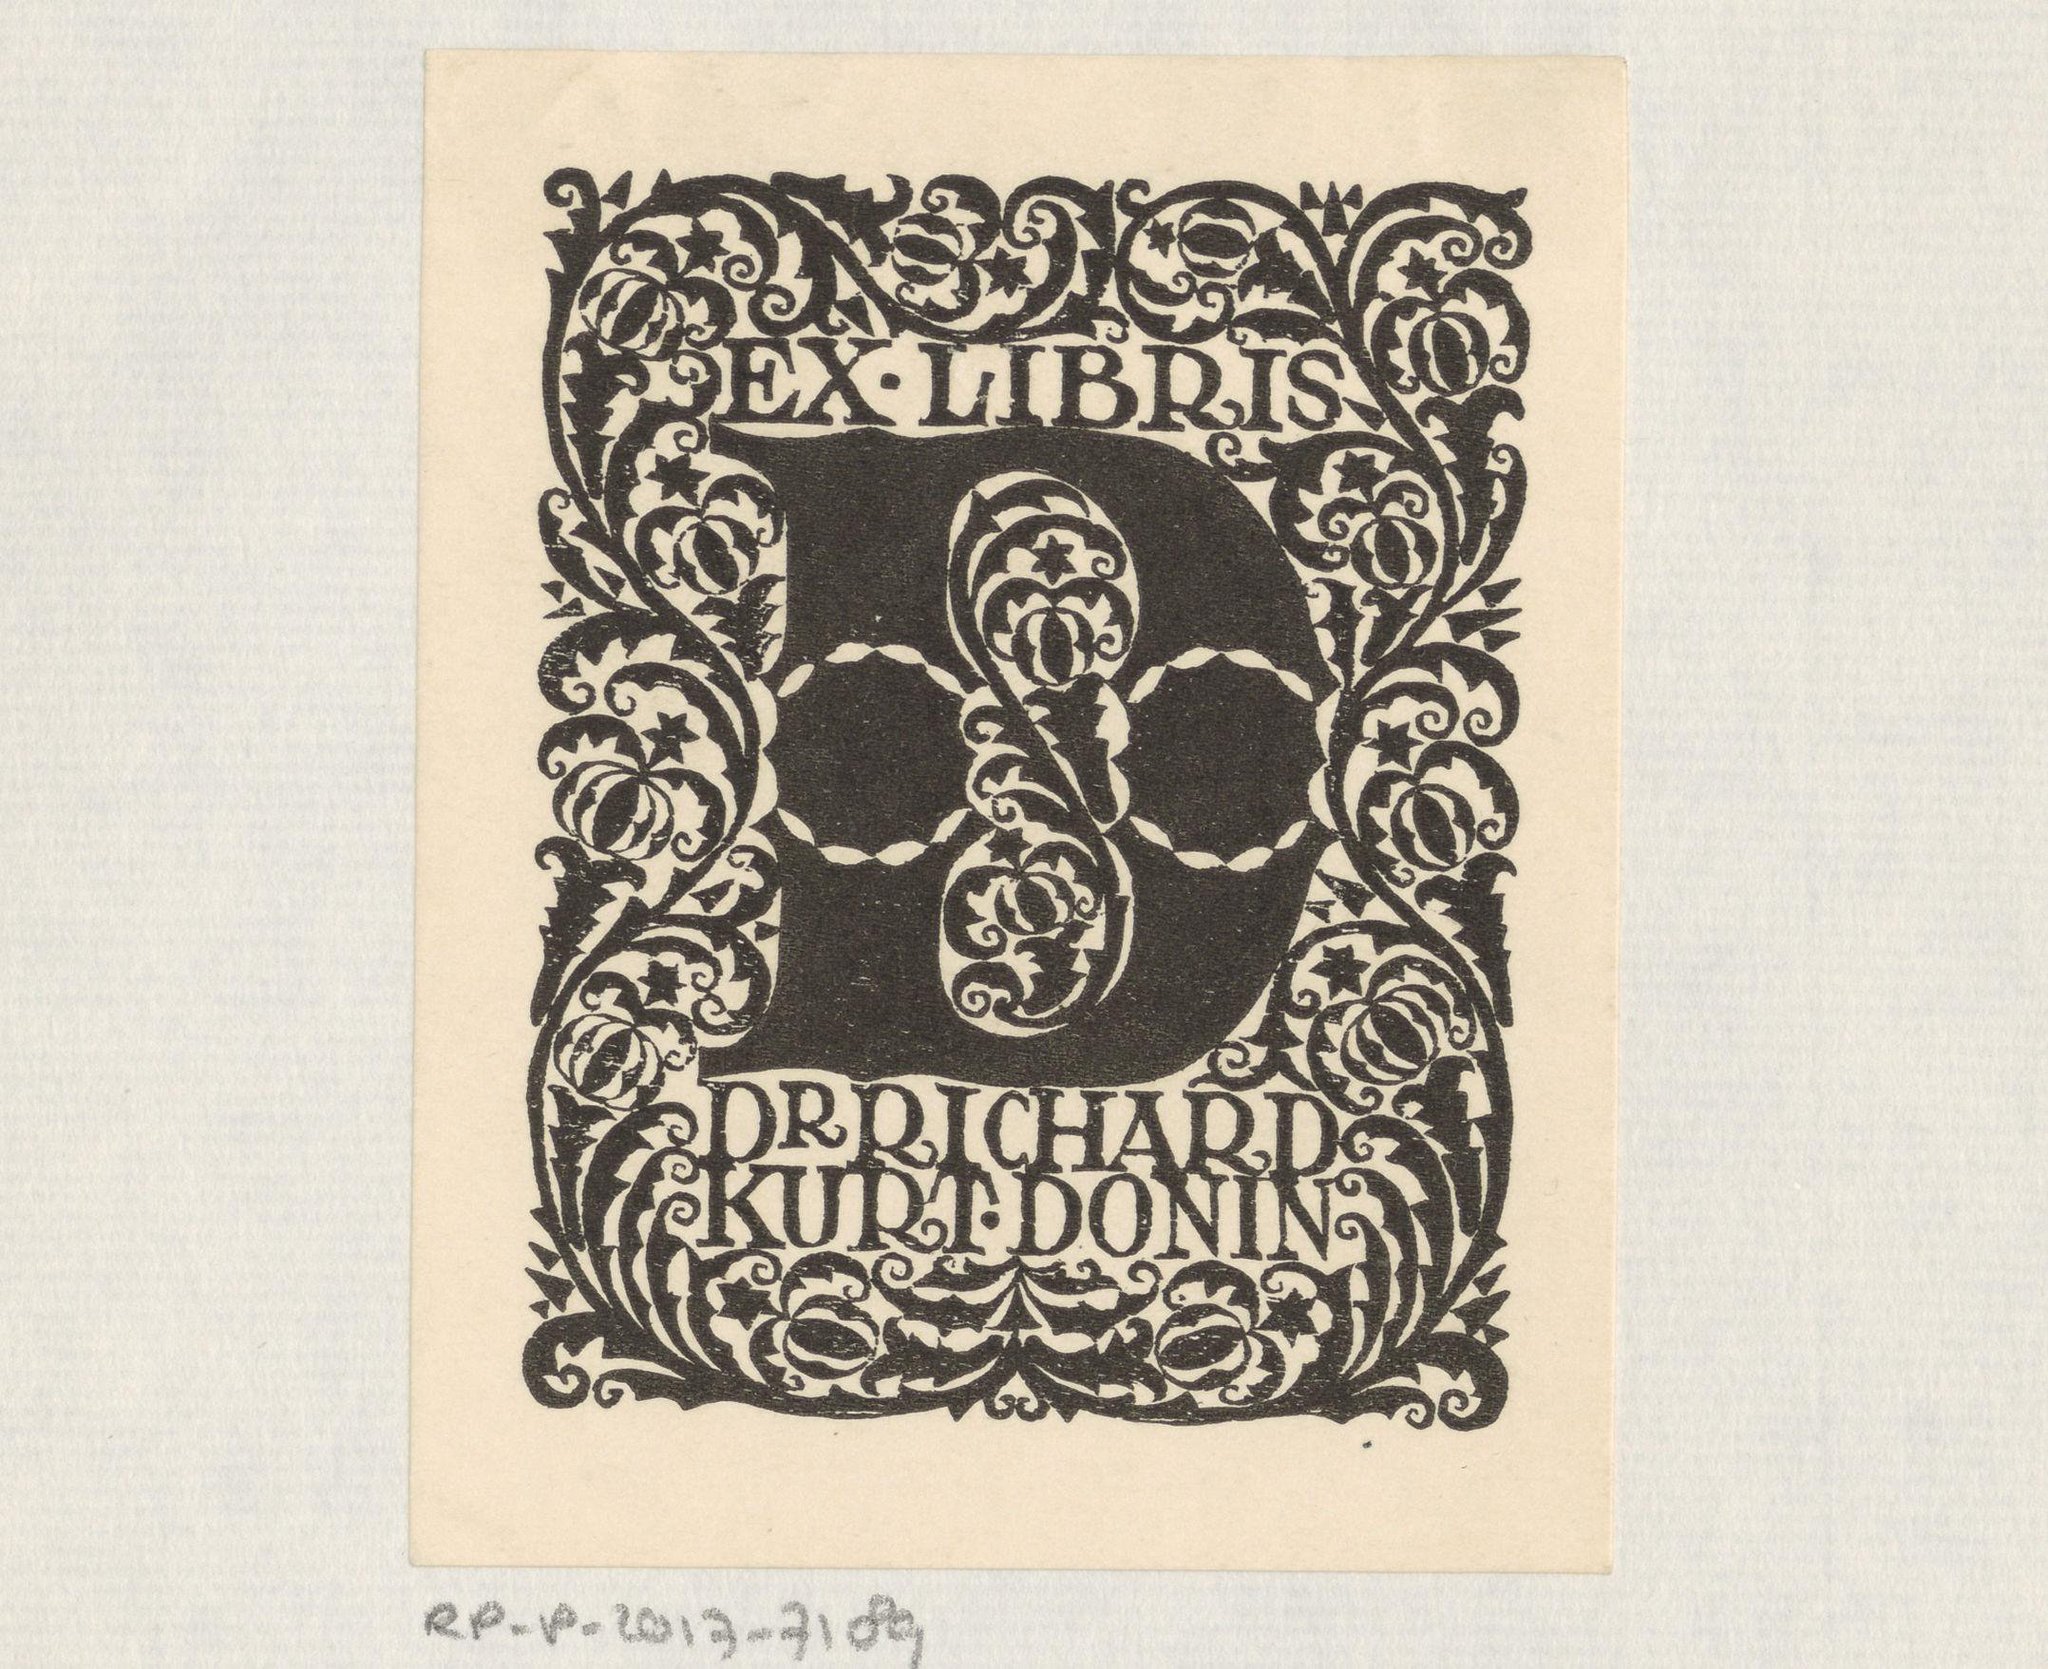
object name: bookplate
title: Ex libris van Richard Kurt Donin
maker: rudolf junk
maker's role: painter, print maker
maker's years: 1880-1943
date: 1891-1943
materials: paper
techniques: woodcut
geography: austria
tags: vienna, flowers ~ ornament - aa - stylized